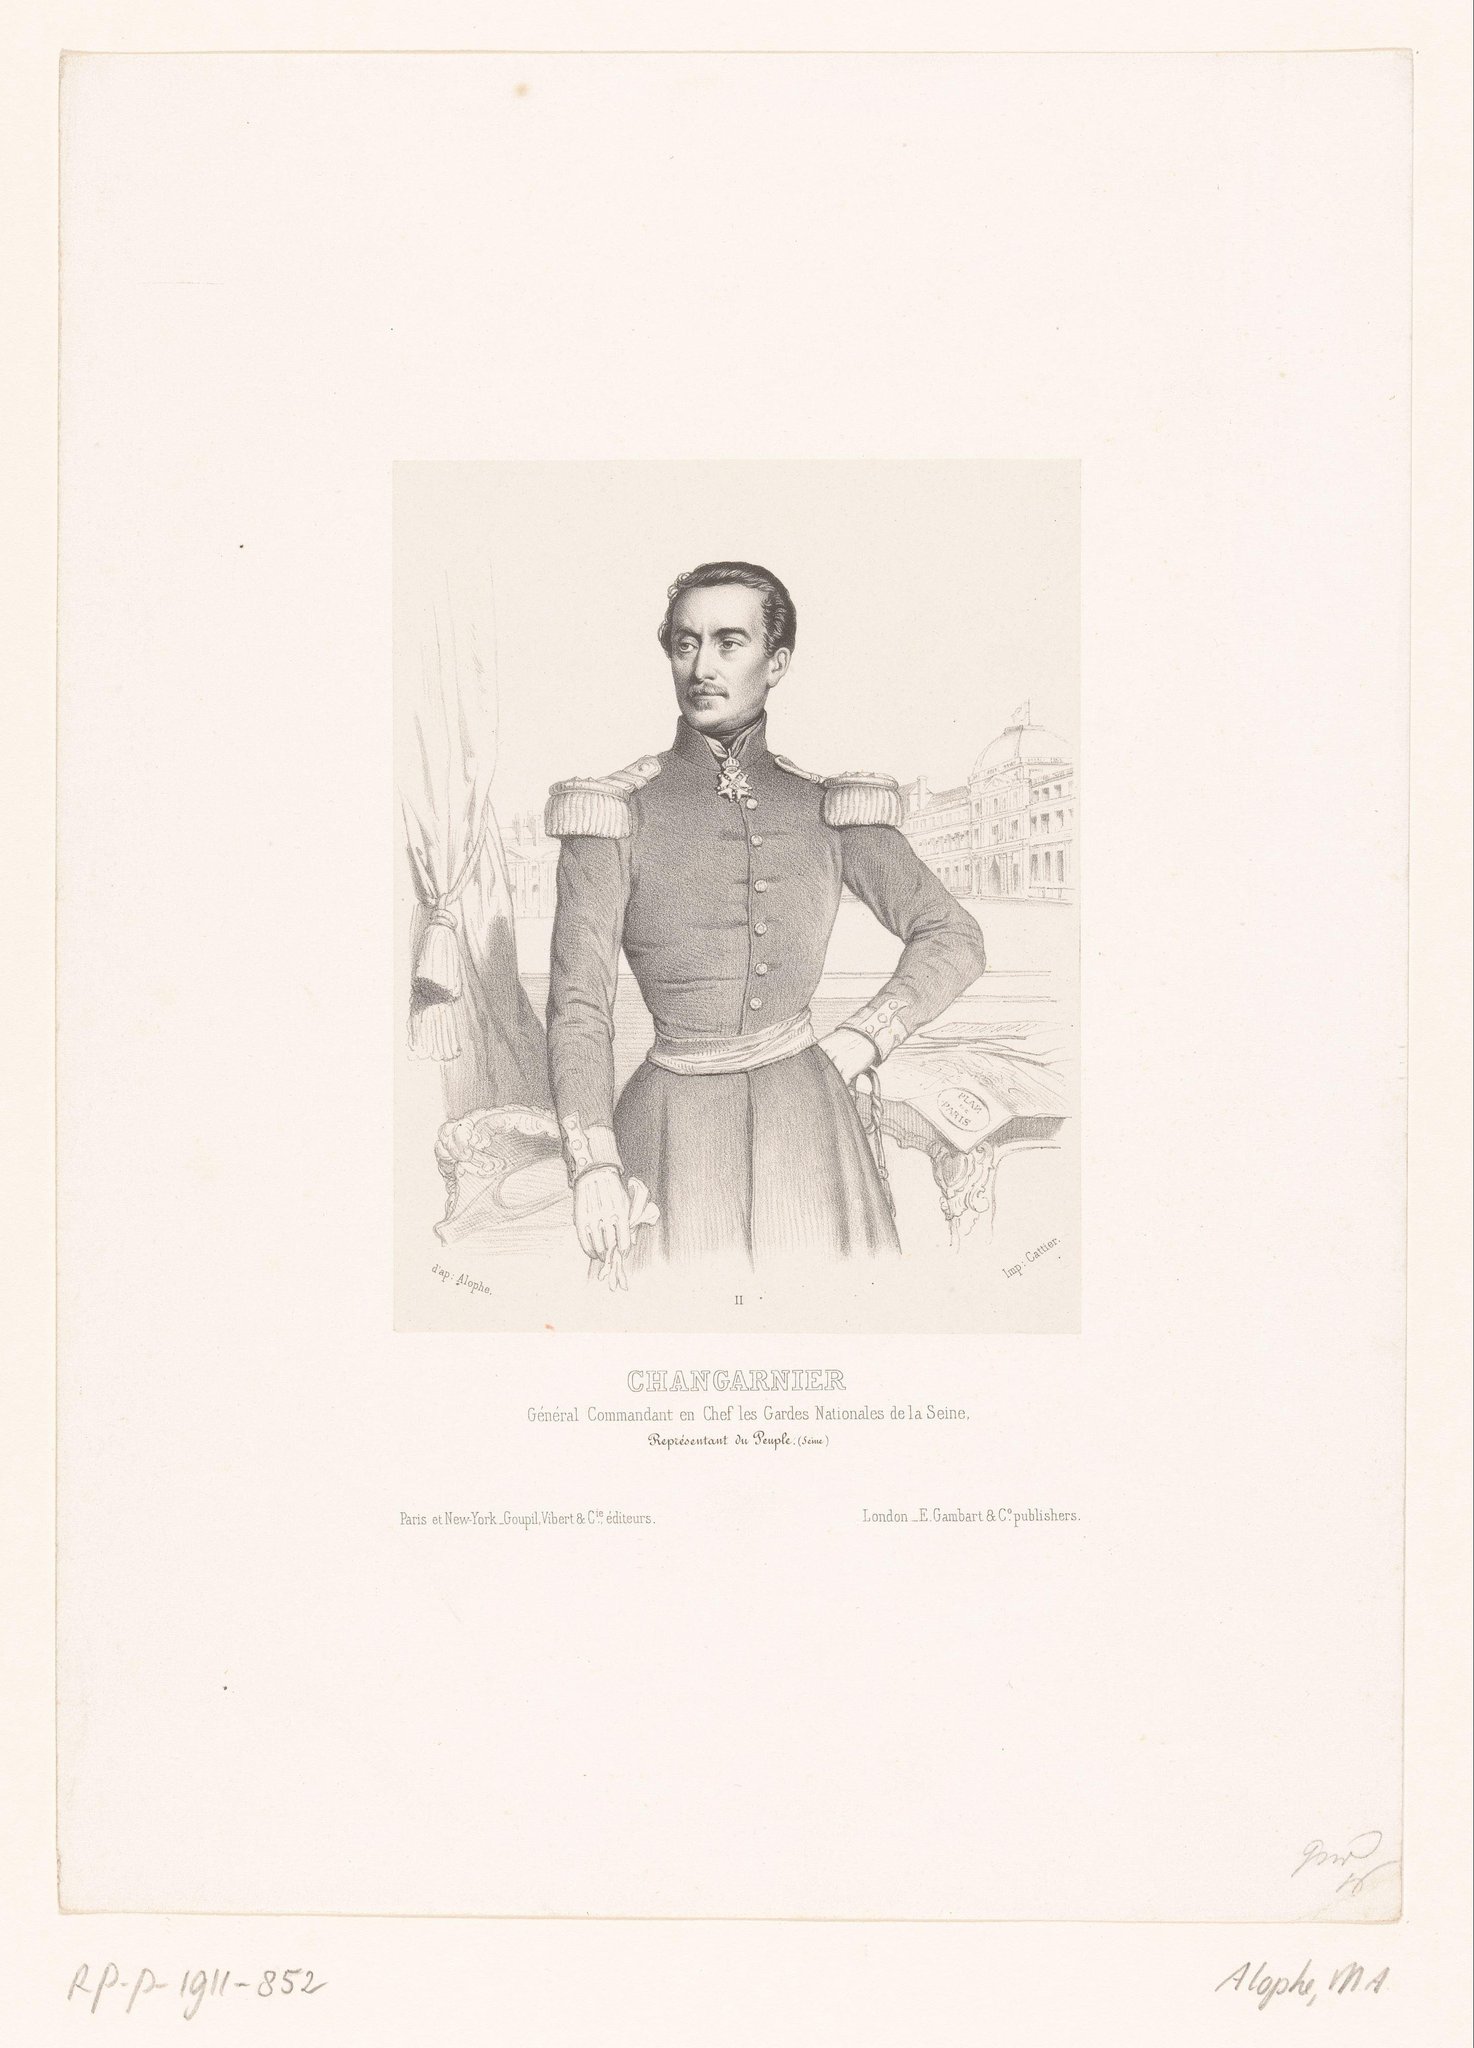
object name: print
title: Changarnier. Général commandant en chef les gardes nationales de la Seine, représentant du peuple (Seine)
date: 1848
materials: paper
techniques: lithography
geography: new york city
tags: historical persons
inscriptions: number: ‘[...] 16’, check stamp: Lugt 5004, collector's mark: Lugt 2228